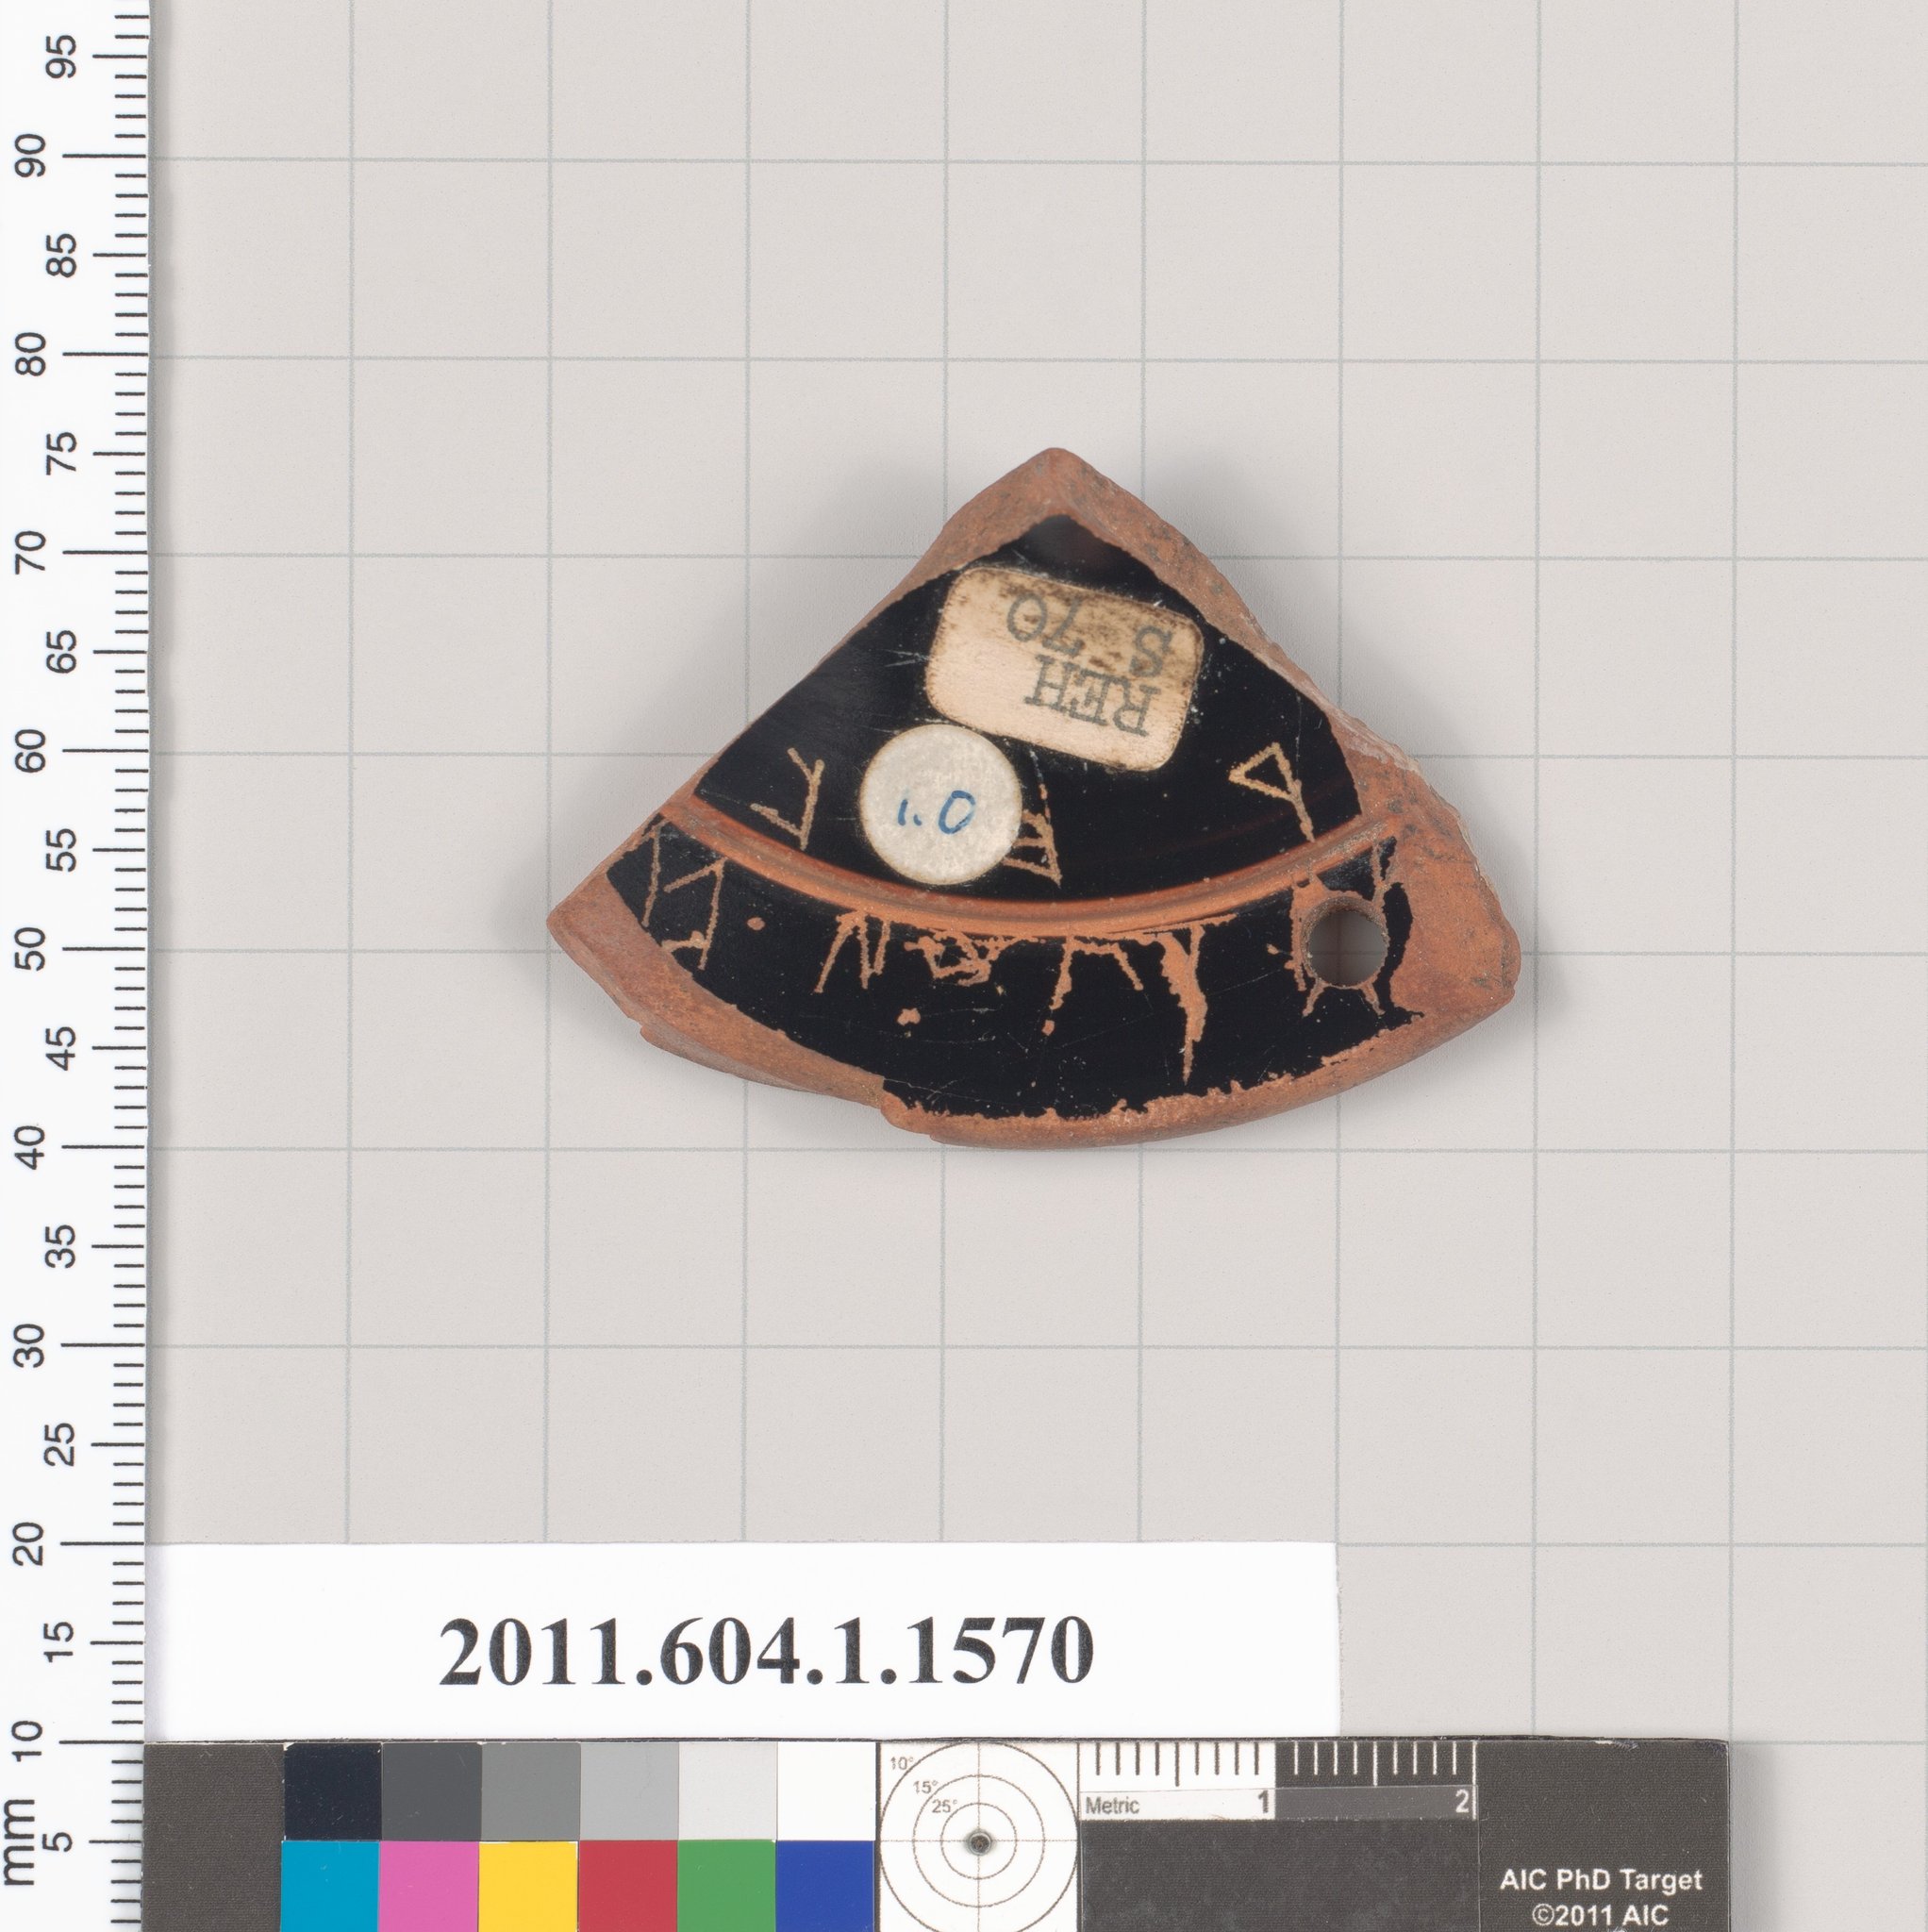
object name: kylix fragment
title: Terracotta fragment of a kylix (drinking cup)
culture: greek, attic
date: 500-401 BCE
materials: terracotta